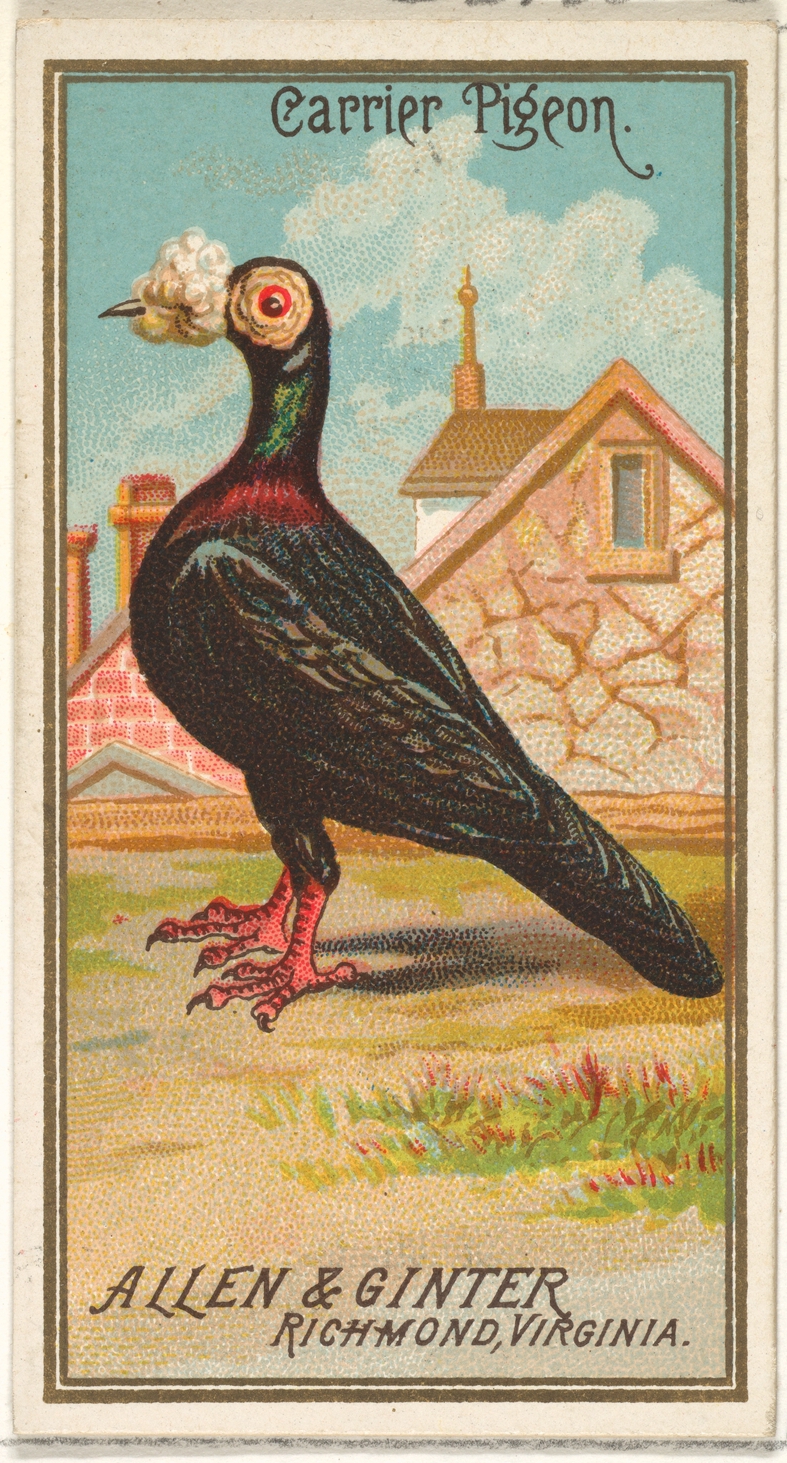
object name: print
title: Carrier Pigeon, from the Birds of America series (N4) for Allen & Ginter Cigarettes Brands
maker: allen & ginter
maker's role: publisher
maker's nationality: american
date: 1888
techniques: color lithograph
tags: pigeons